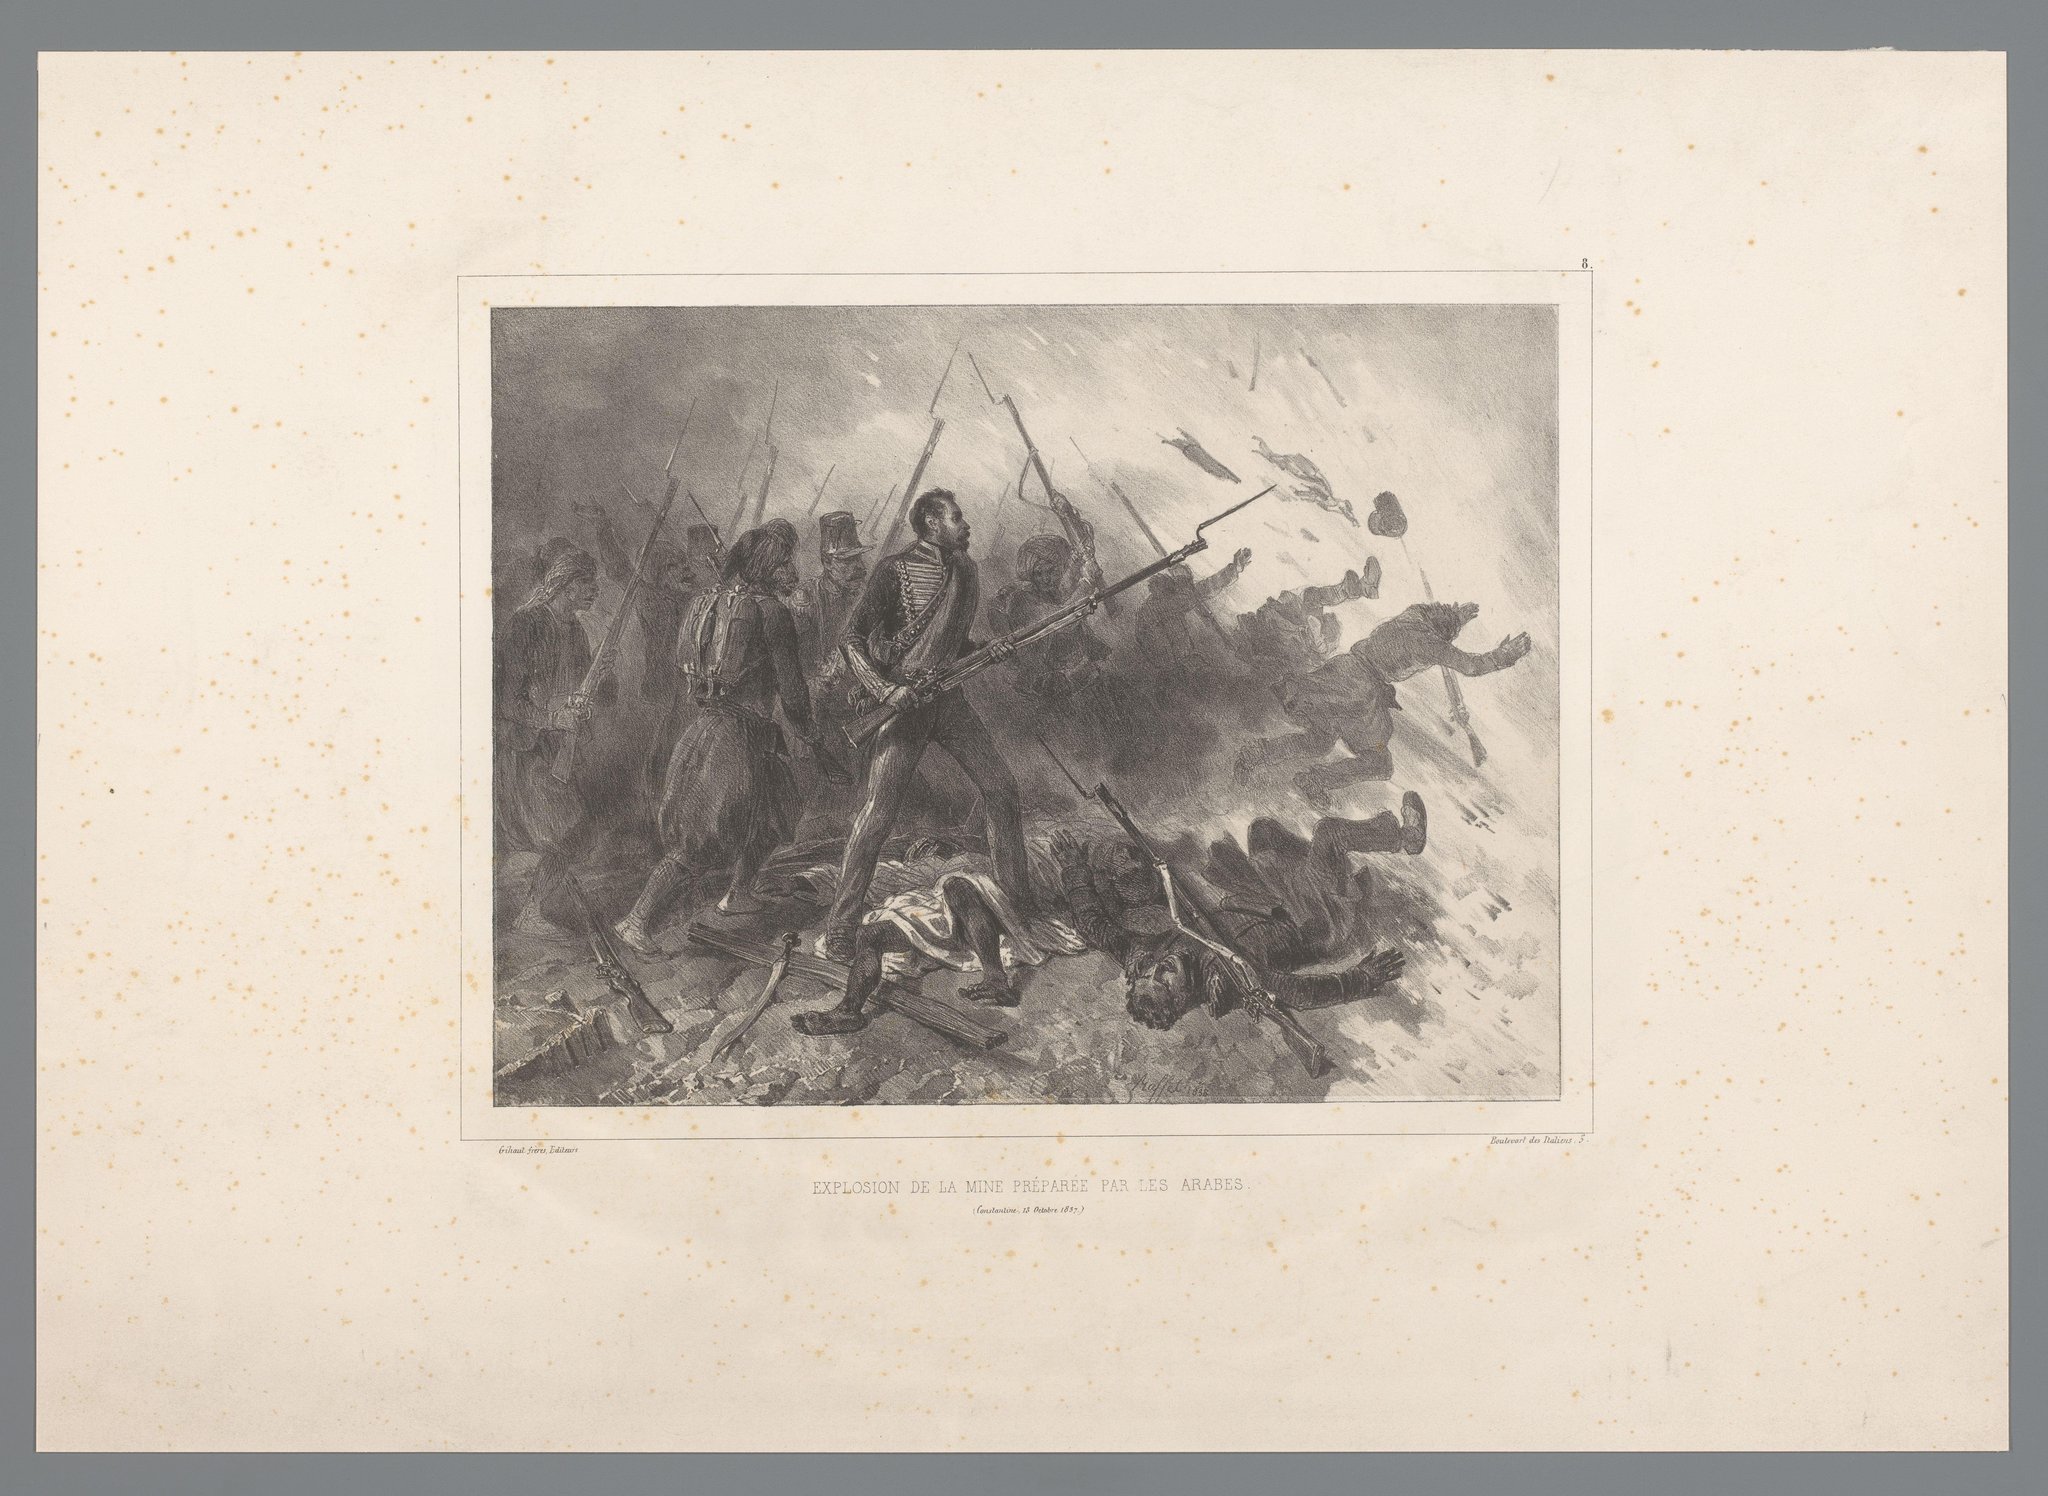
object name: print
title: Prise de Constantine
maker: denis auguste marie raffet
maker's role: draughtsman, print maker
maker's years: 1804-1860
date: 1838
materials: paper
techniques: lithograph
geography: paris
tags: projectiles, explosives, etc.: mine, firearms: rifle, (military) attack, the soldier; the soldier's life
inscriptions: collector's mark: Lugt 2760, collector's mark: Lugt 2228